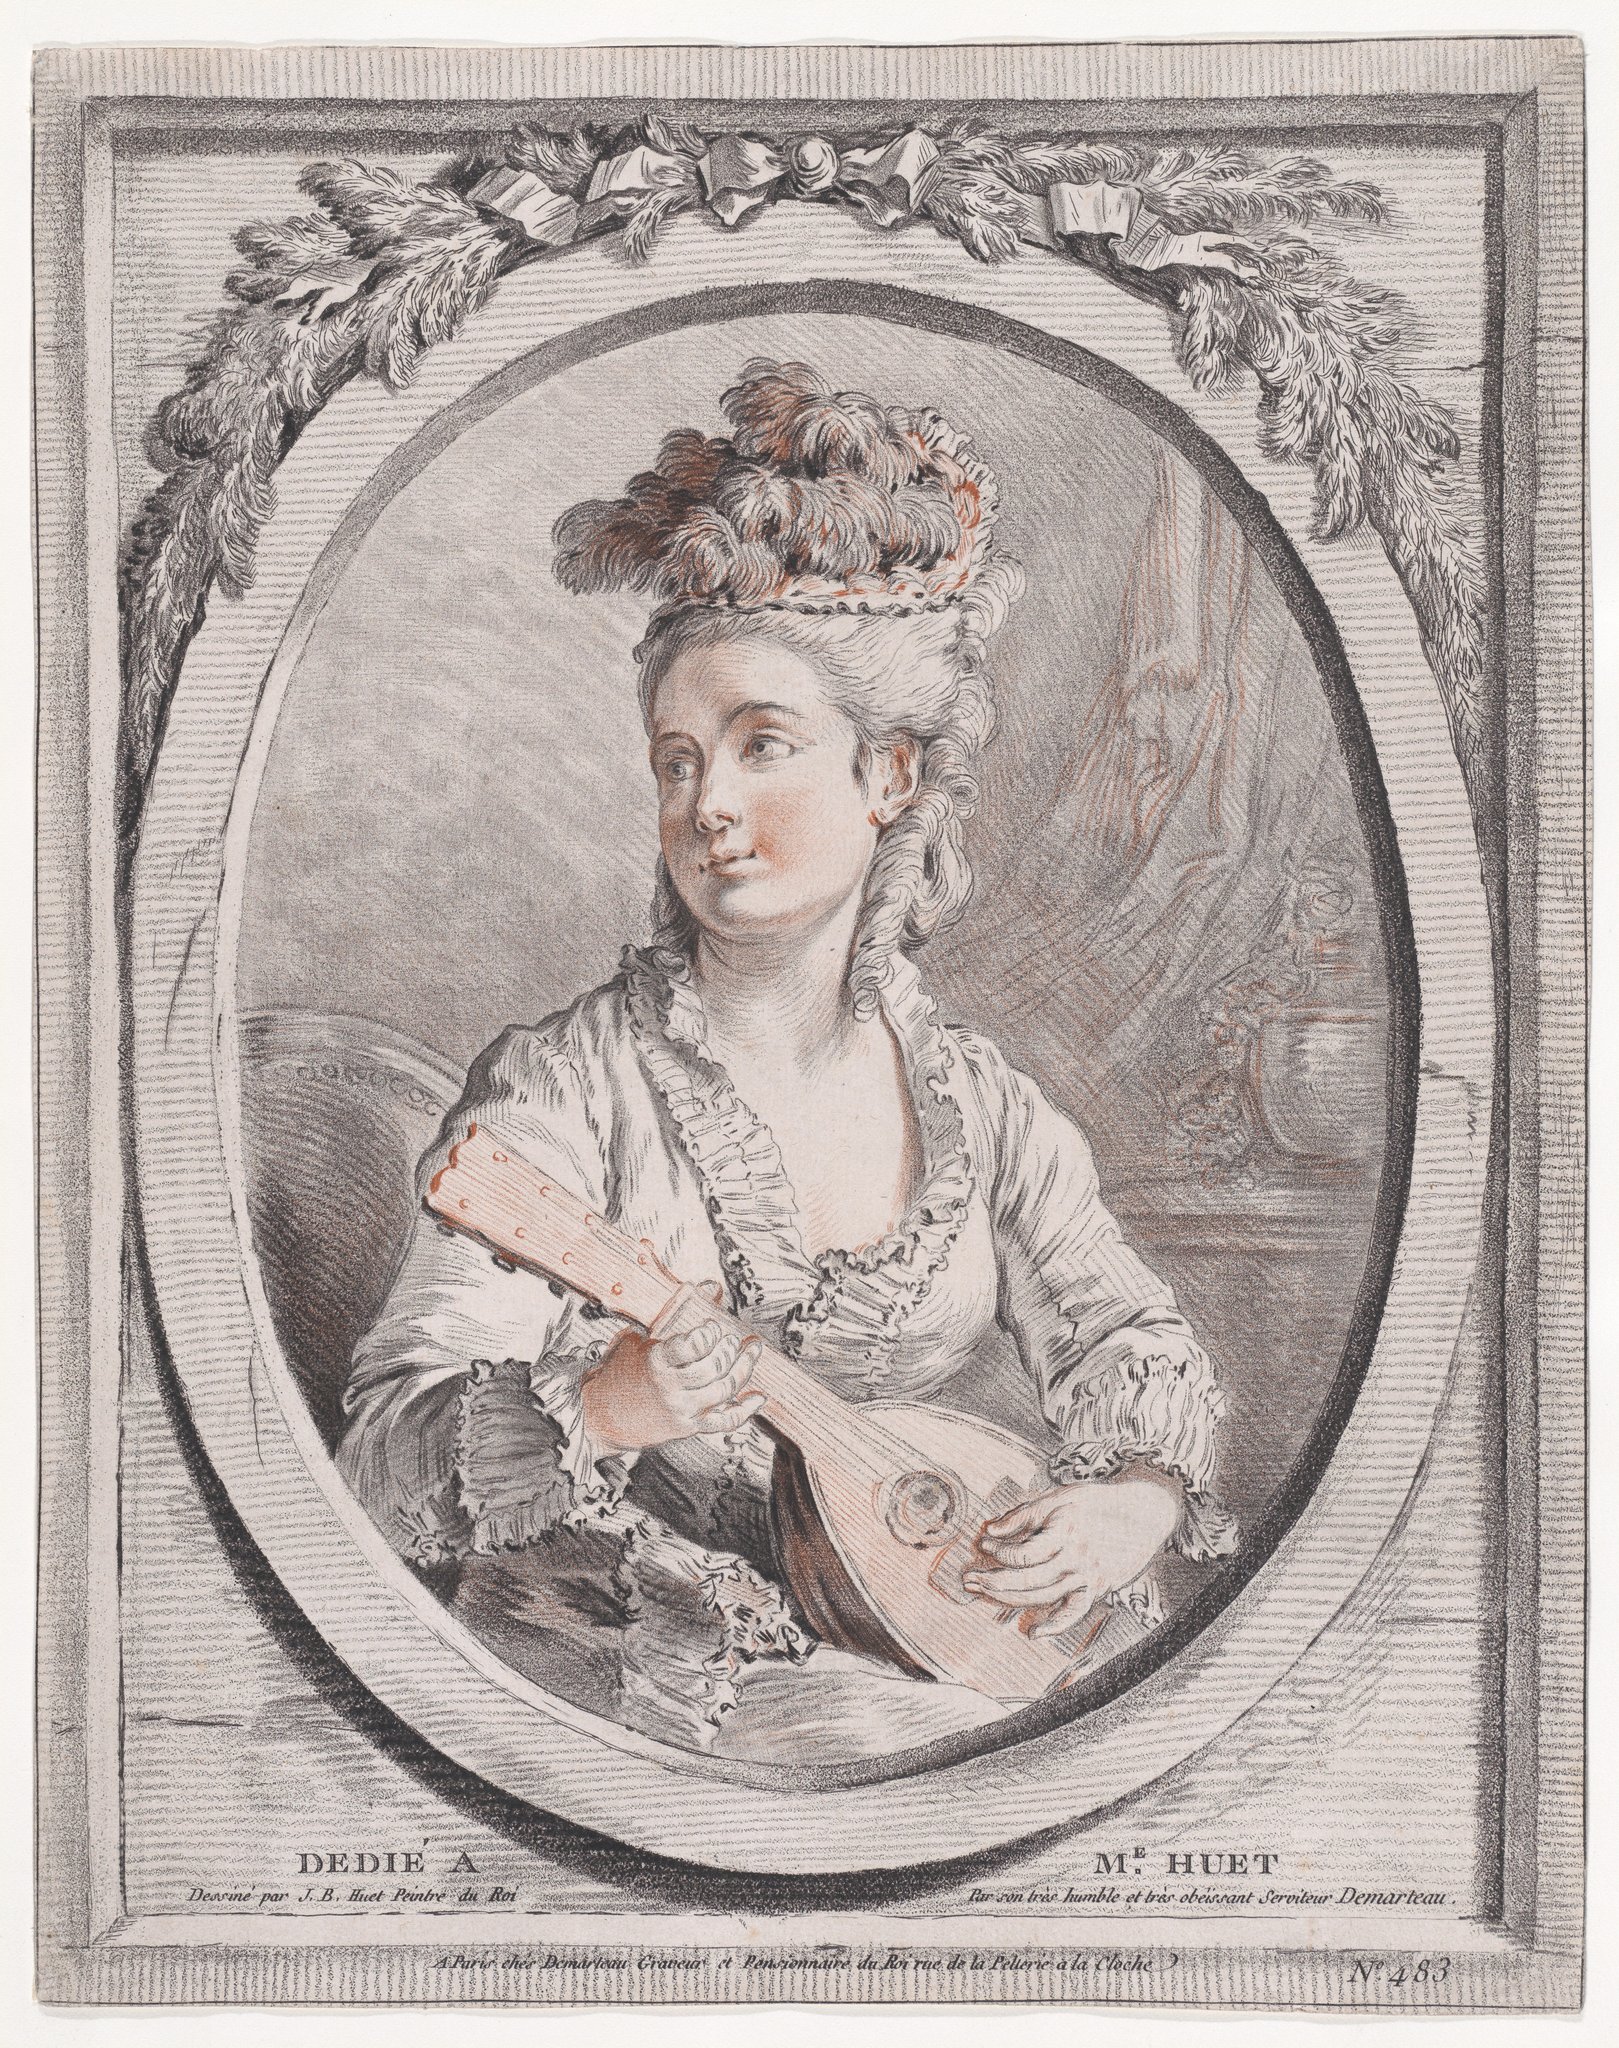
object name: print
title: Musicienne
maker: gilles demarteau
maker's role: artist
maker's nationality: french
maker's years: 1722-1776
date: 1742-1776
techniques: printmaking, etching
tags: women,lutes,musicians